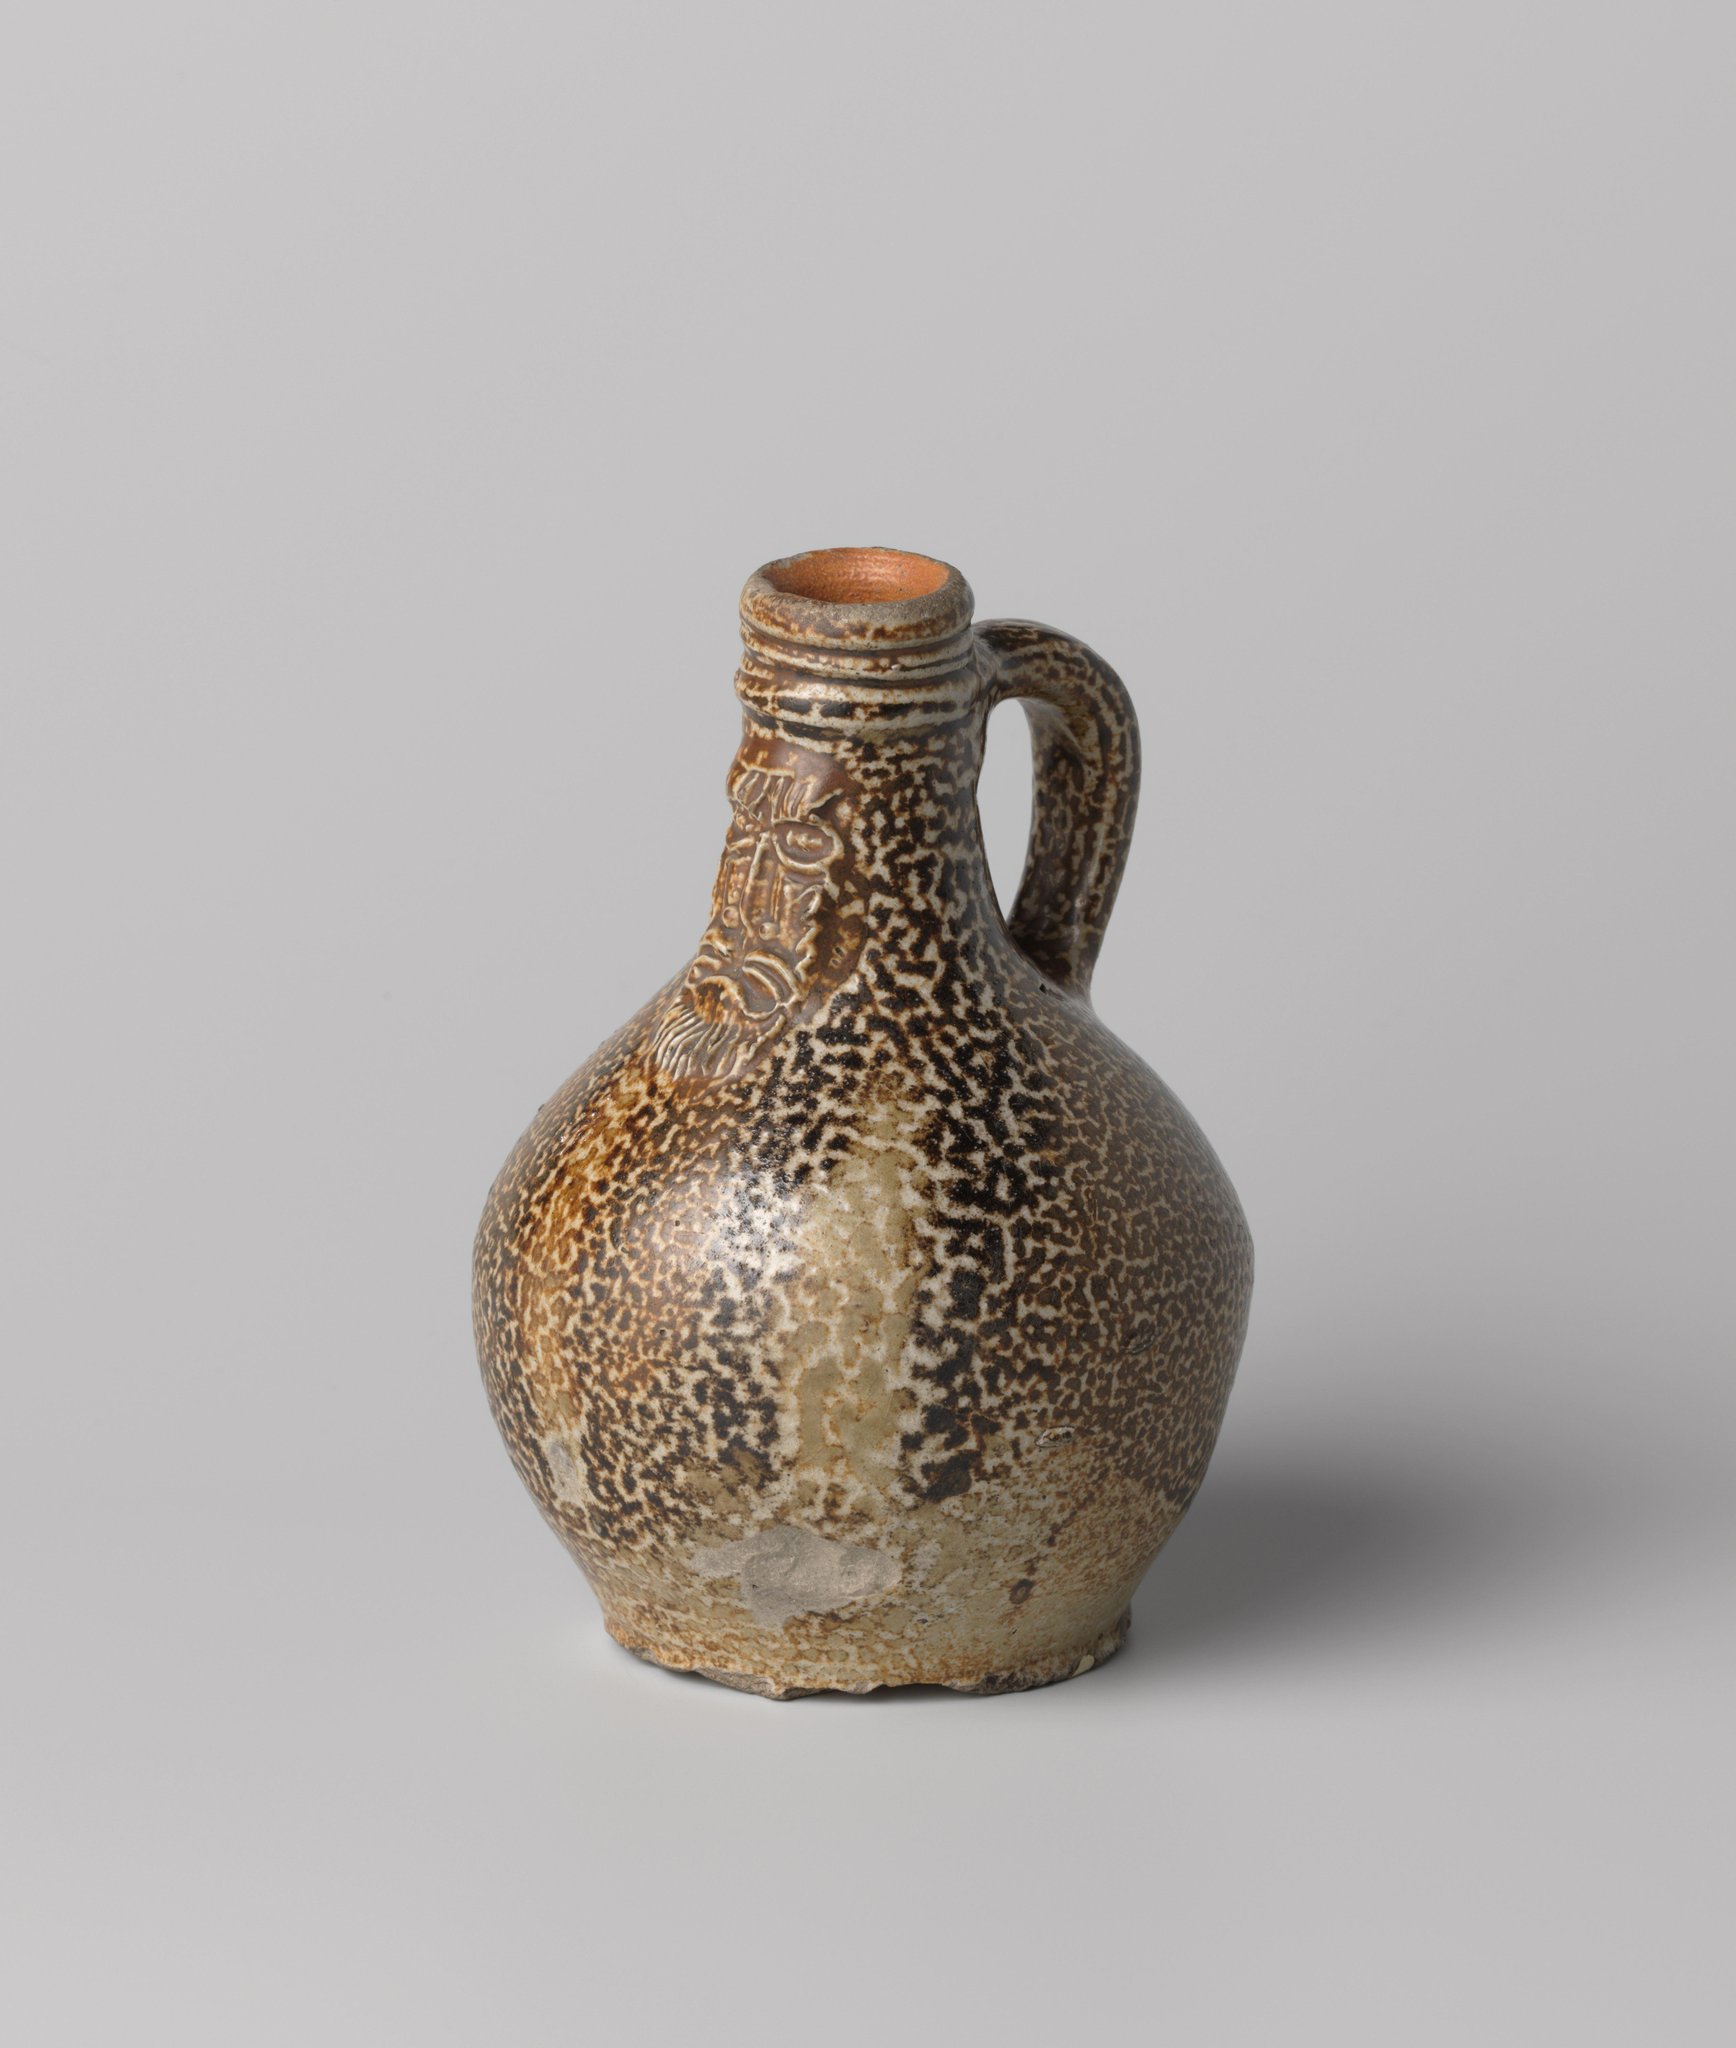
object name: jug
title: Jug (Bartmann jug)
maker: Anonymous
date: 1600-1699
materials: engobe, glaze, stoneware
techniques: firing, forming, relief, turning, vitrification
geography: frechen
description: Kruik (baardmankruik) van steengoed op standvlak met een bolvormig lichaam en smalle nek. Het C-vormige oor is bevestigd aan de nek en de schouder. Profielen op de nek en de voet. Bedekt met een bruine engobe. Op de nek, doorlopend op de schouder, een baardman. Frechen.